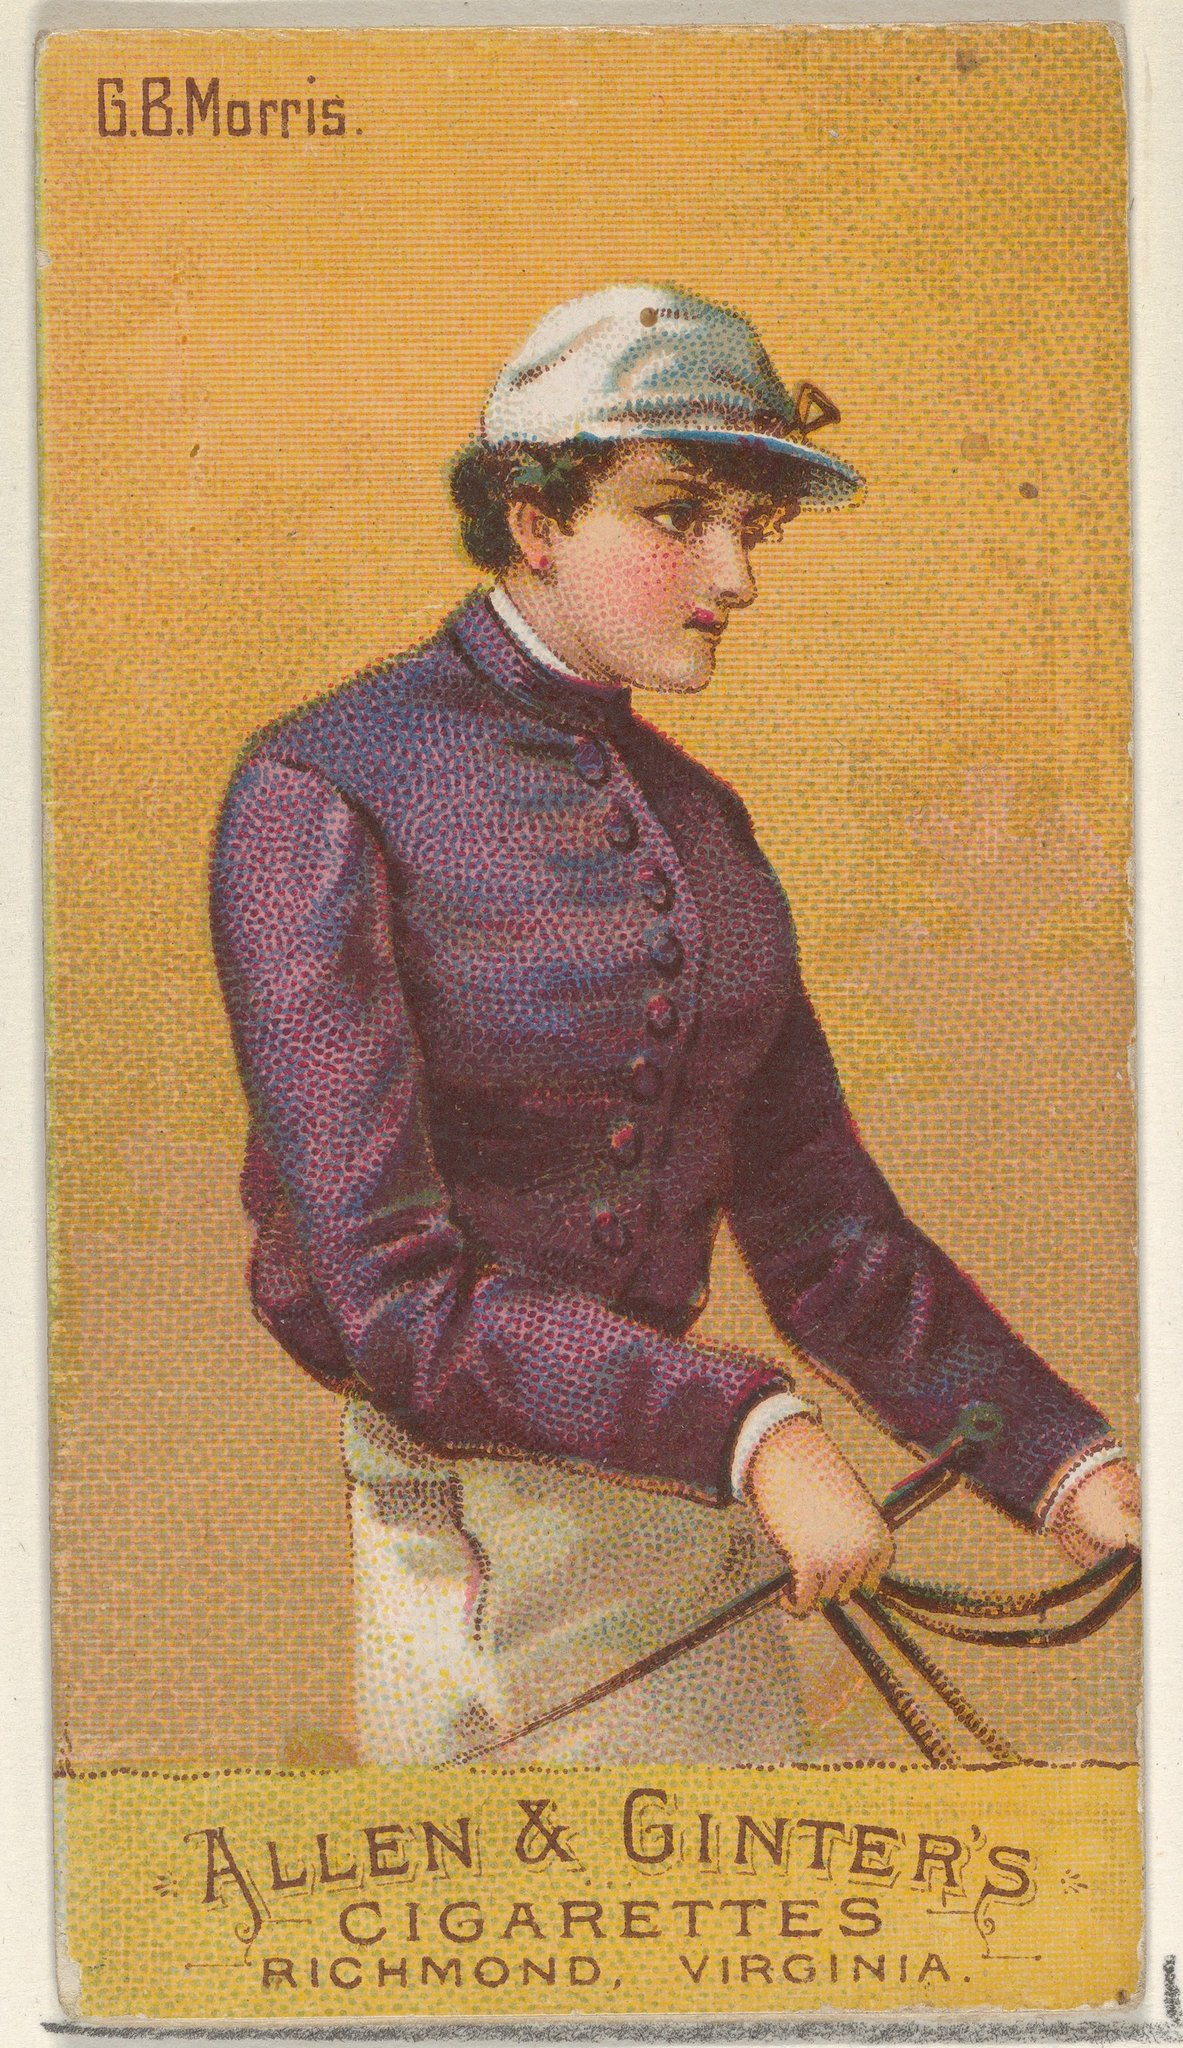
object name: print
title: G.B. Morris, from the Racing Colors of the World series (N22b) for Allen & Ginter Cigarettes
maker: allen & ginter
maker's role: publisher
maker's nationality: american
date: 1888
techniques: color lithograph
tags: women,jockeys